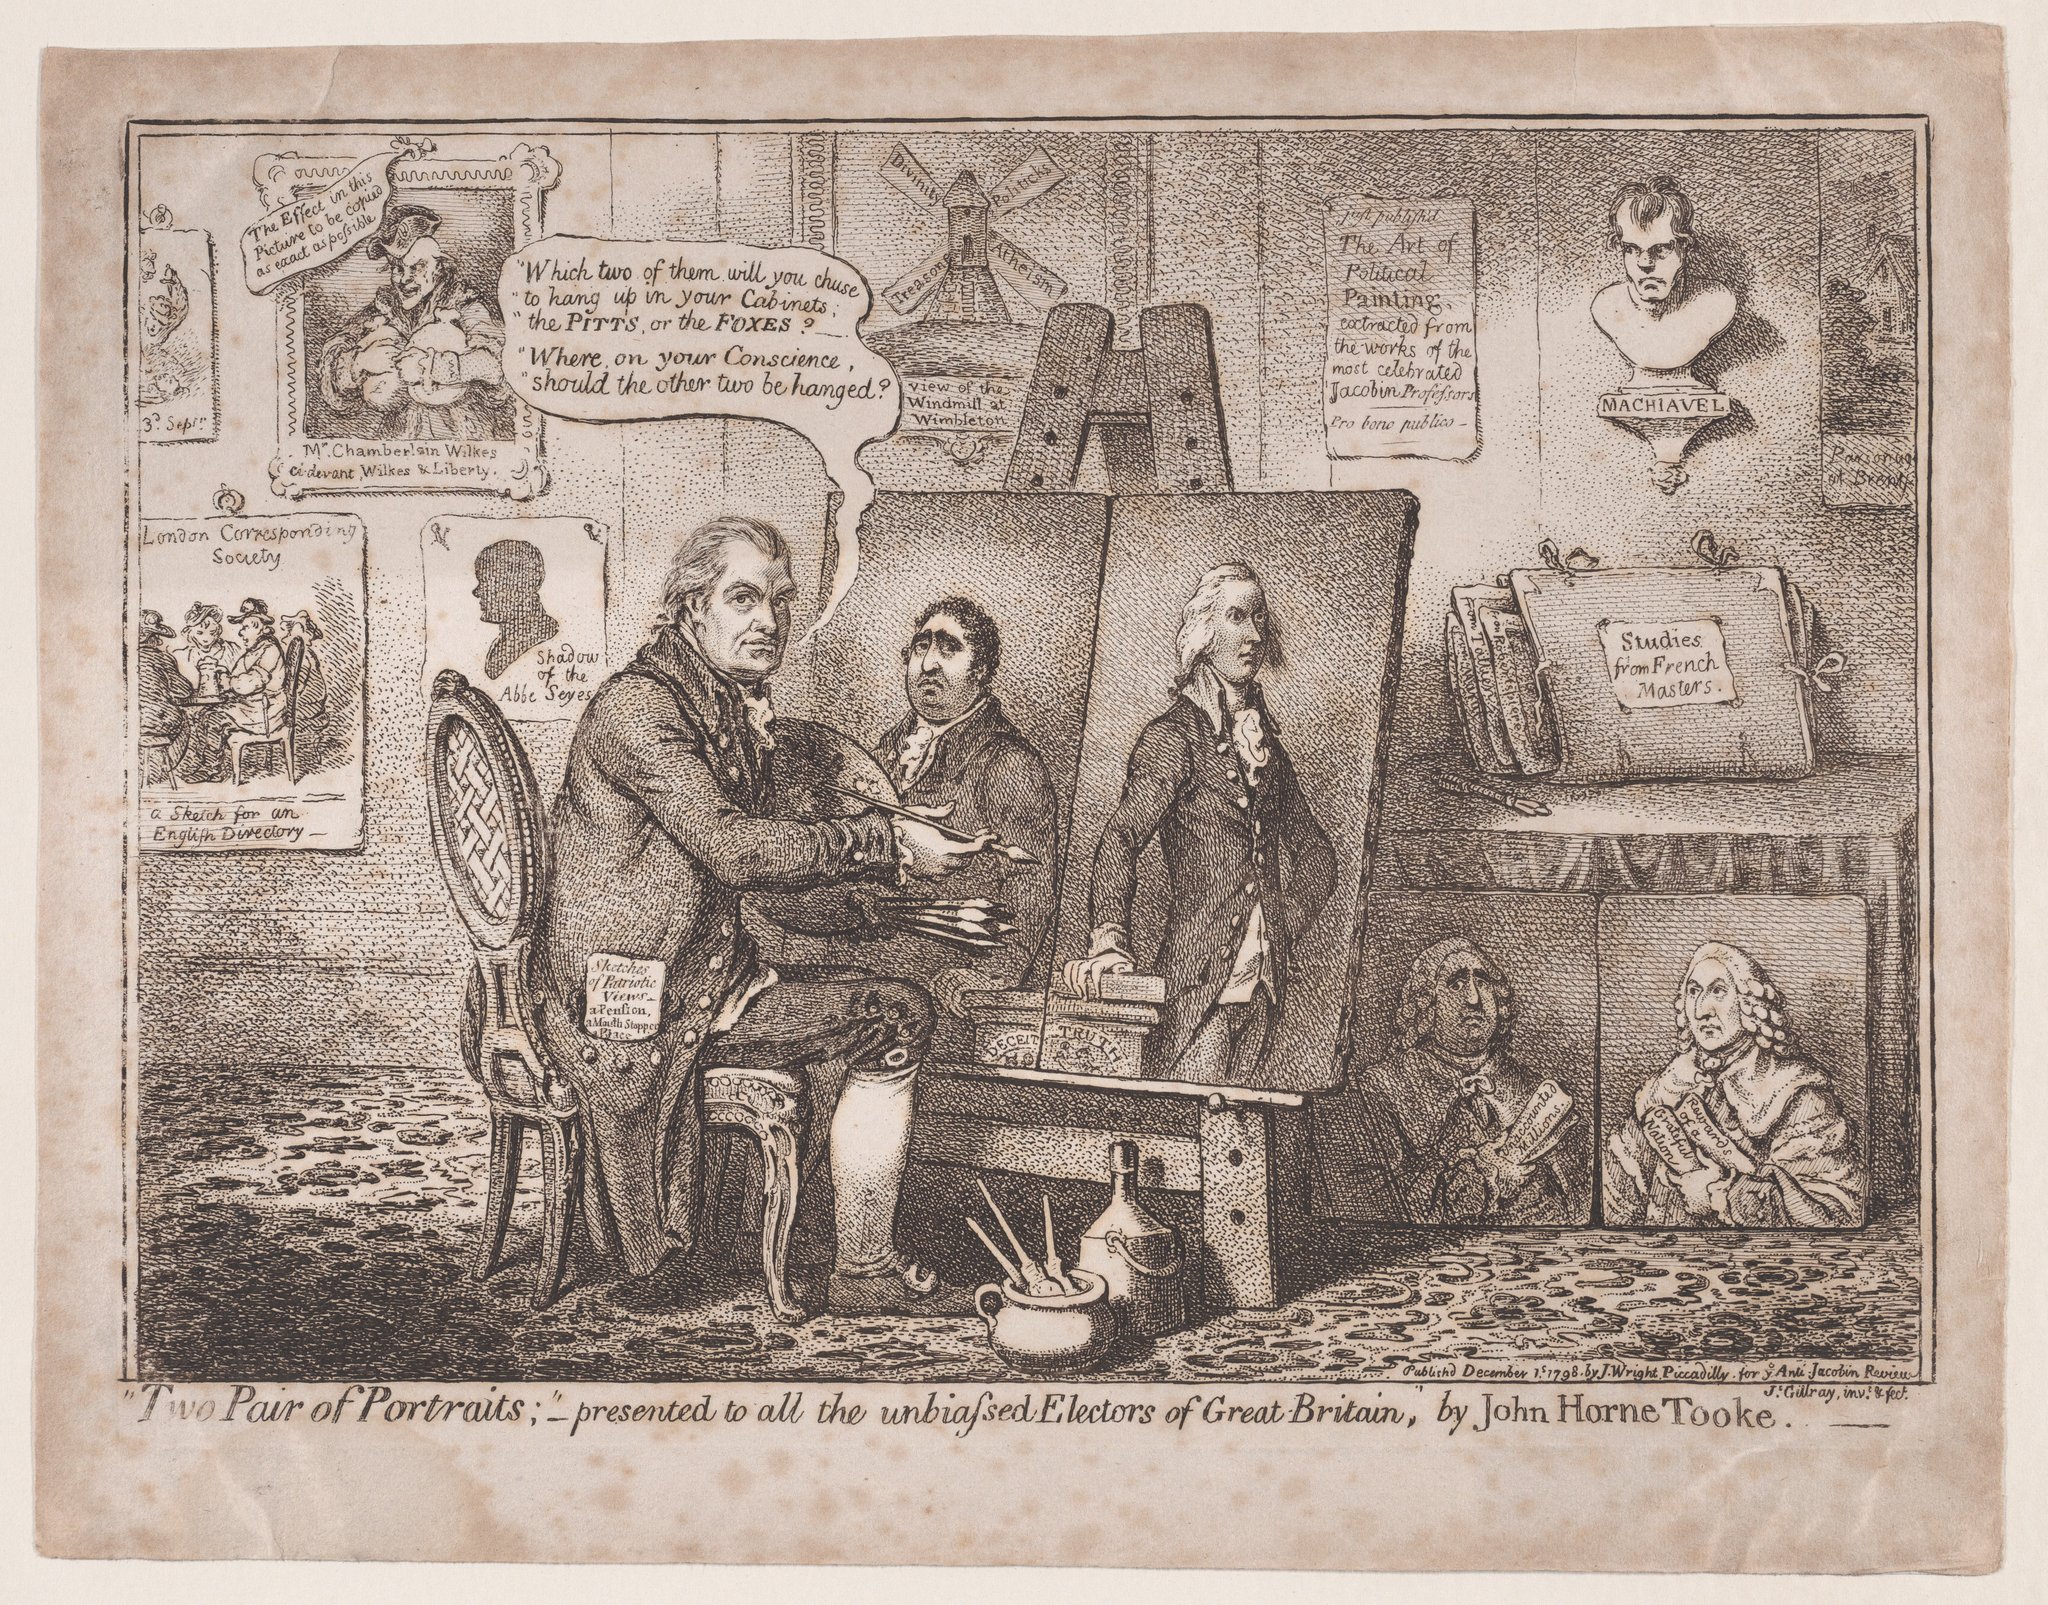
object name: print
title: Two Pair of Portraits, presented to all the unbiased Electors of Great Britain by John Horne Tooke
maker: james gillray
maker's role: artist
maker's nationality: british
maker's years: 1756-1815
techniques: engraving, etching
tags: painting,satire,men,artists,politics,easels